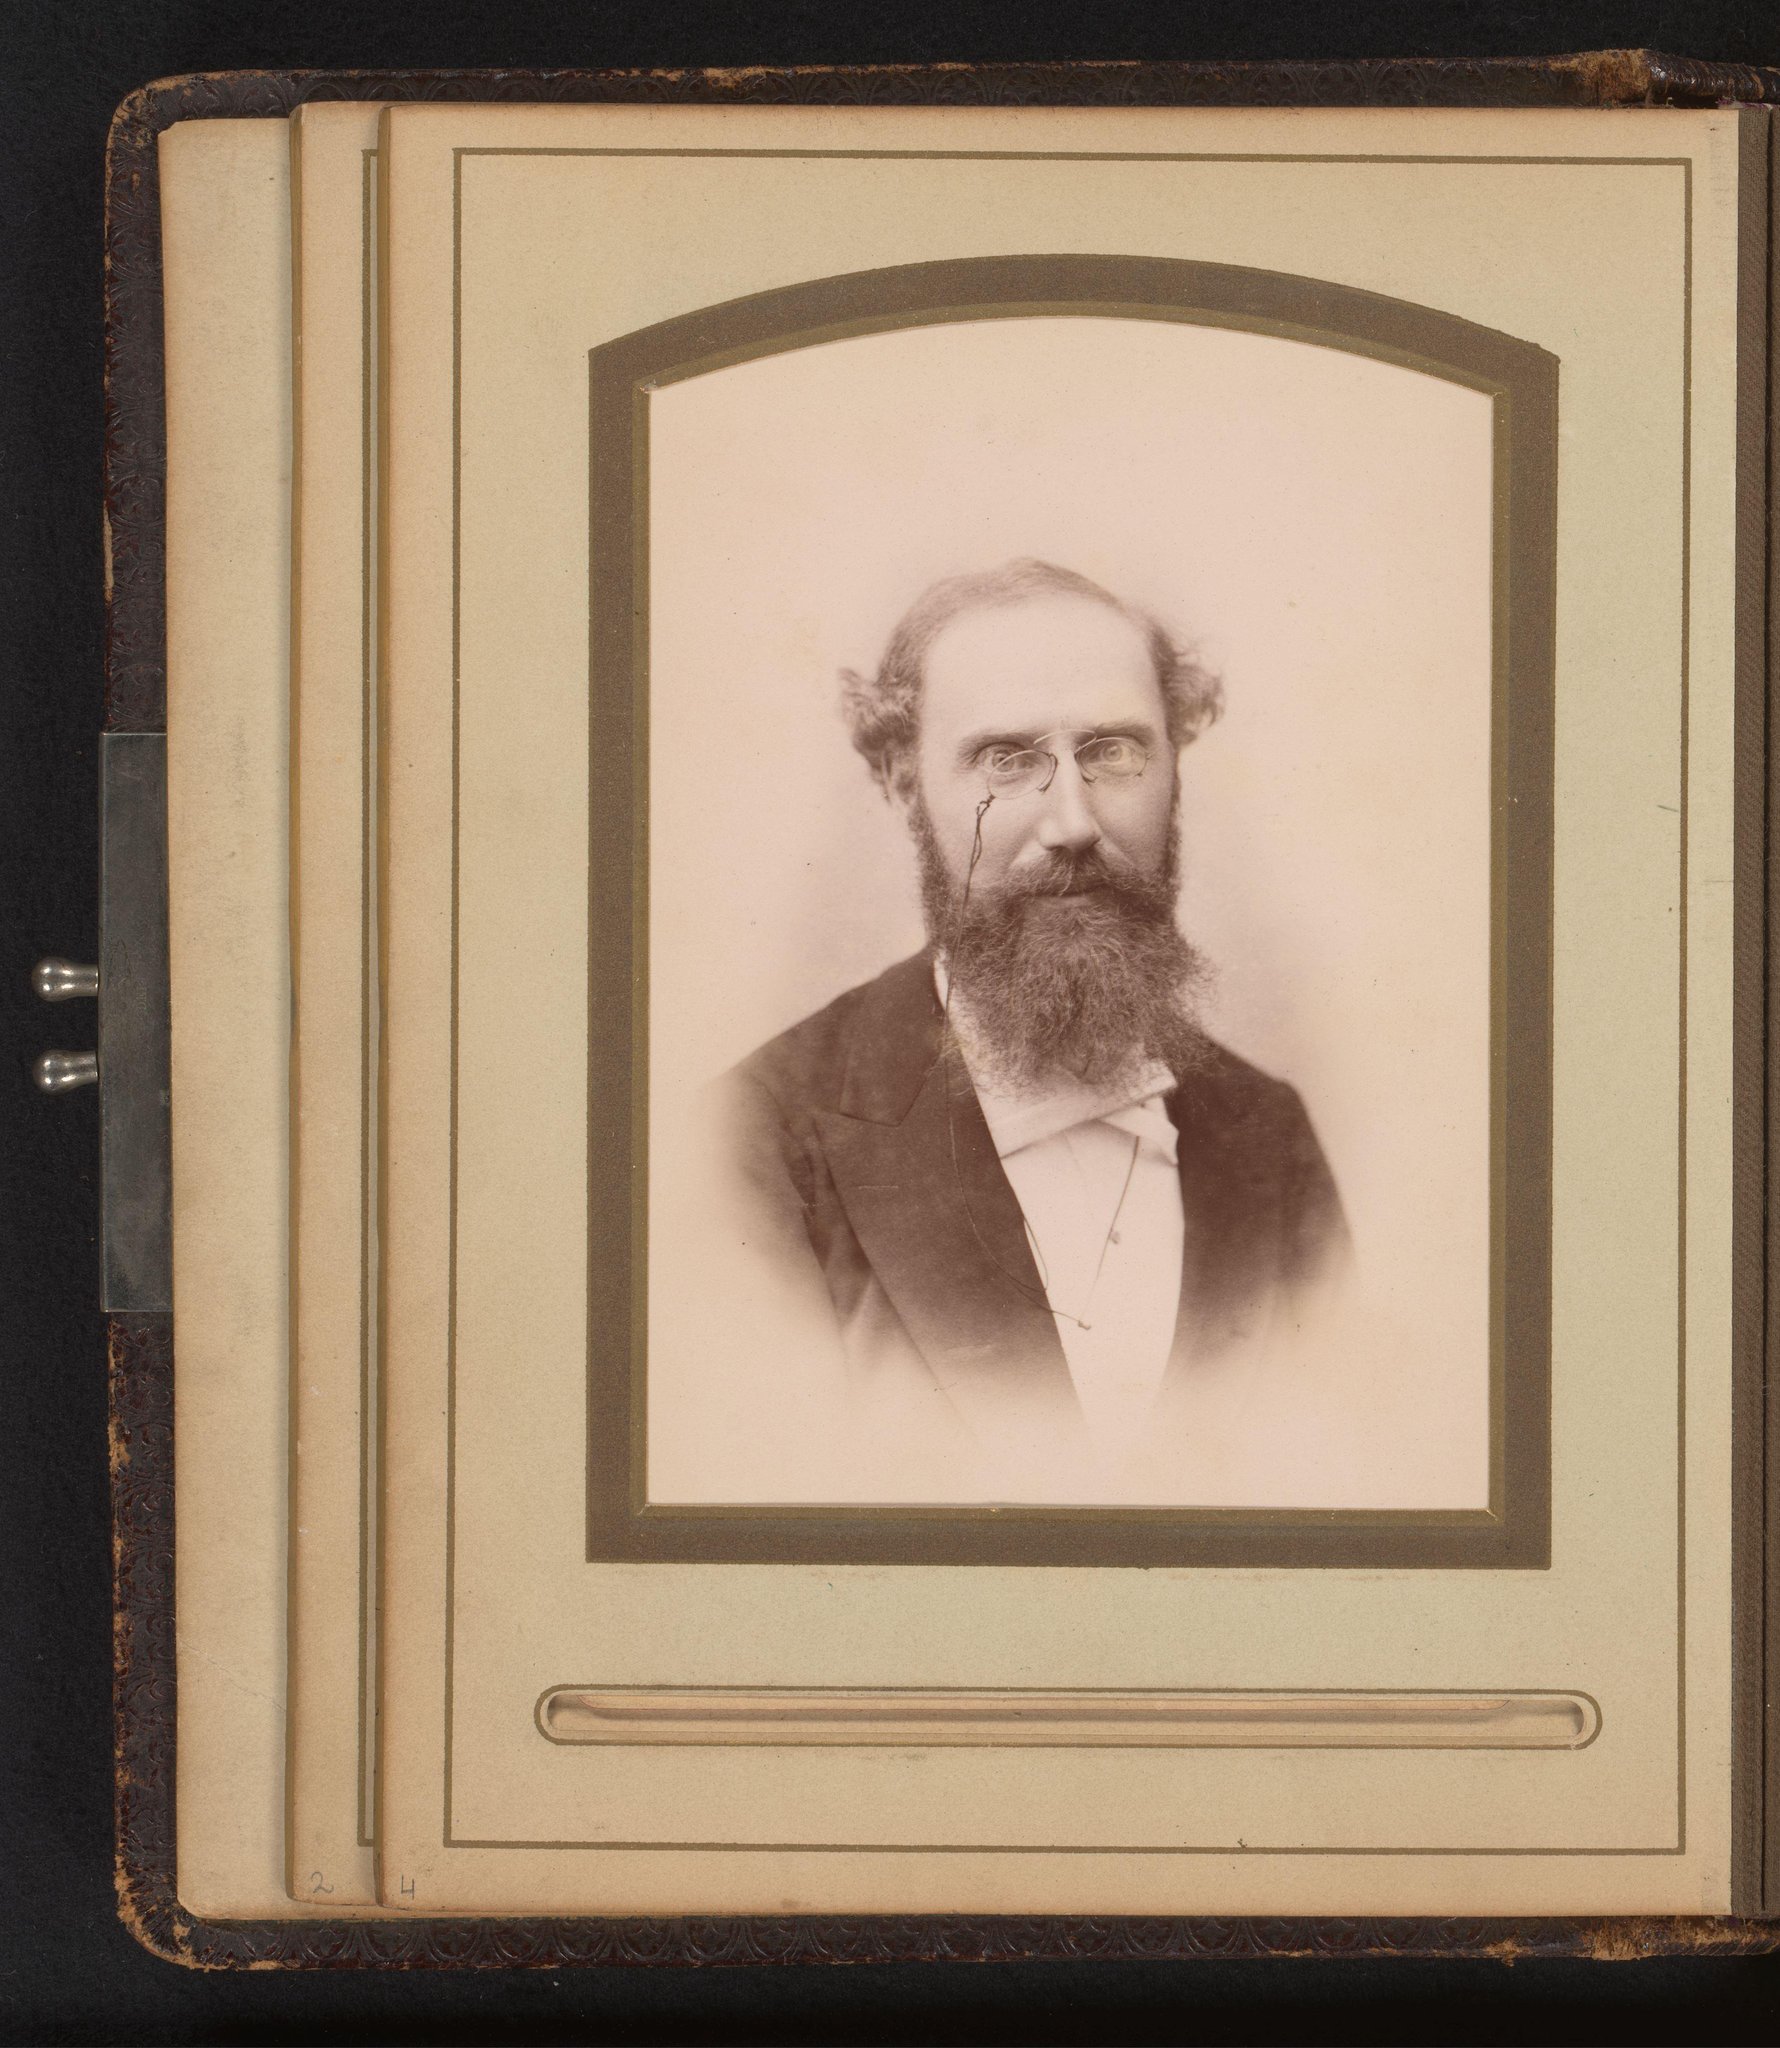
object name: photograph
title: Portret van een man met bril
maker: berger (fotograaf)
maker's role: fotograaf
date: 1880-1940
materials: cardboard, photographic support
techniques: collodion silver print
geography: paris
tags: eyeglasses, spectacles, historical persons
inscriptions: inscription: ‘Photographie/ des/ Champs Elysées/ 28. Avenue des Champs Elysées/ Transférée/ 112, Rue de Courcelles/ Levallois-Paris.’